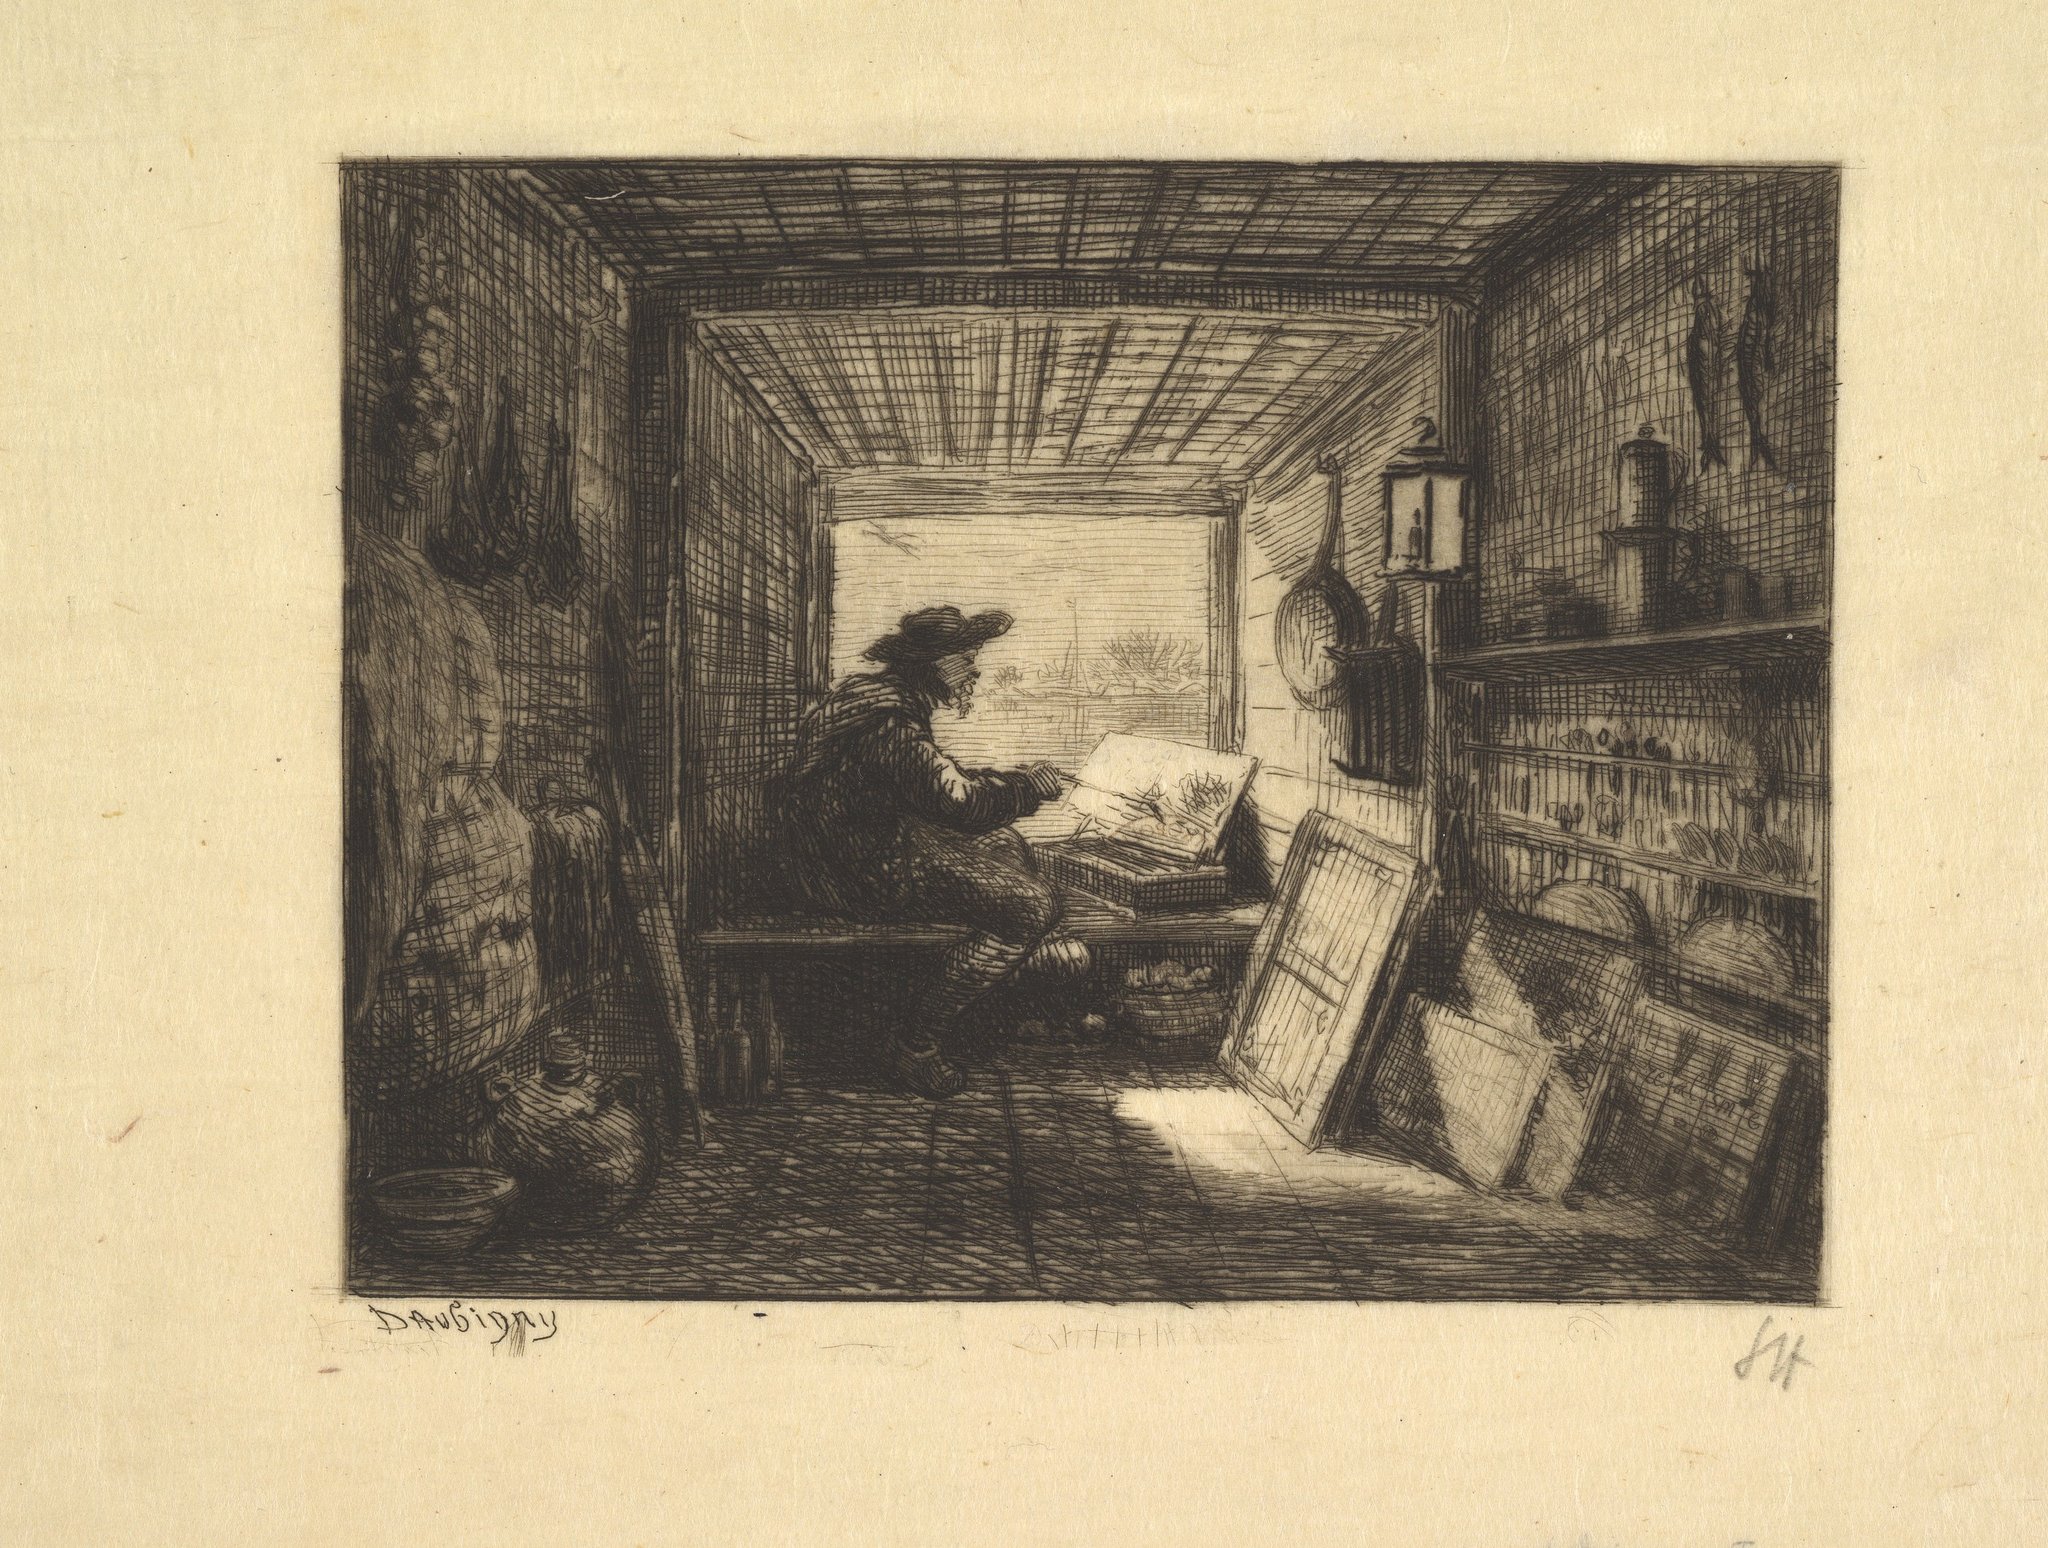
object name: print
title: The Boat Studio, plate 11 from "Voyage en Bateau"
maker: charles-françois daubigny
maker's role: artist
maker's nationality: french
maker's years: 1817-1878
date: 1861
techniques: etching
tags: painting,men